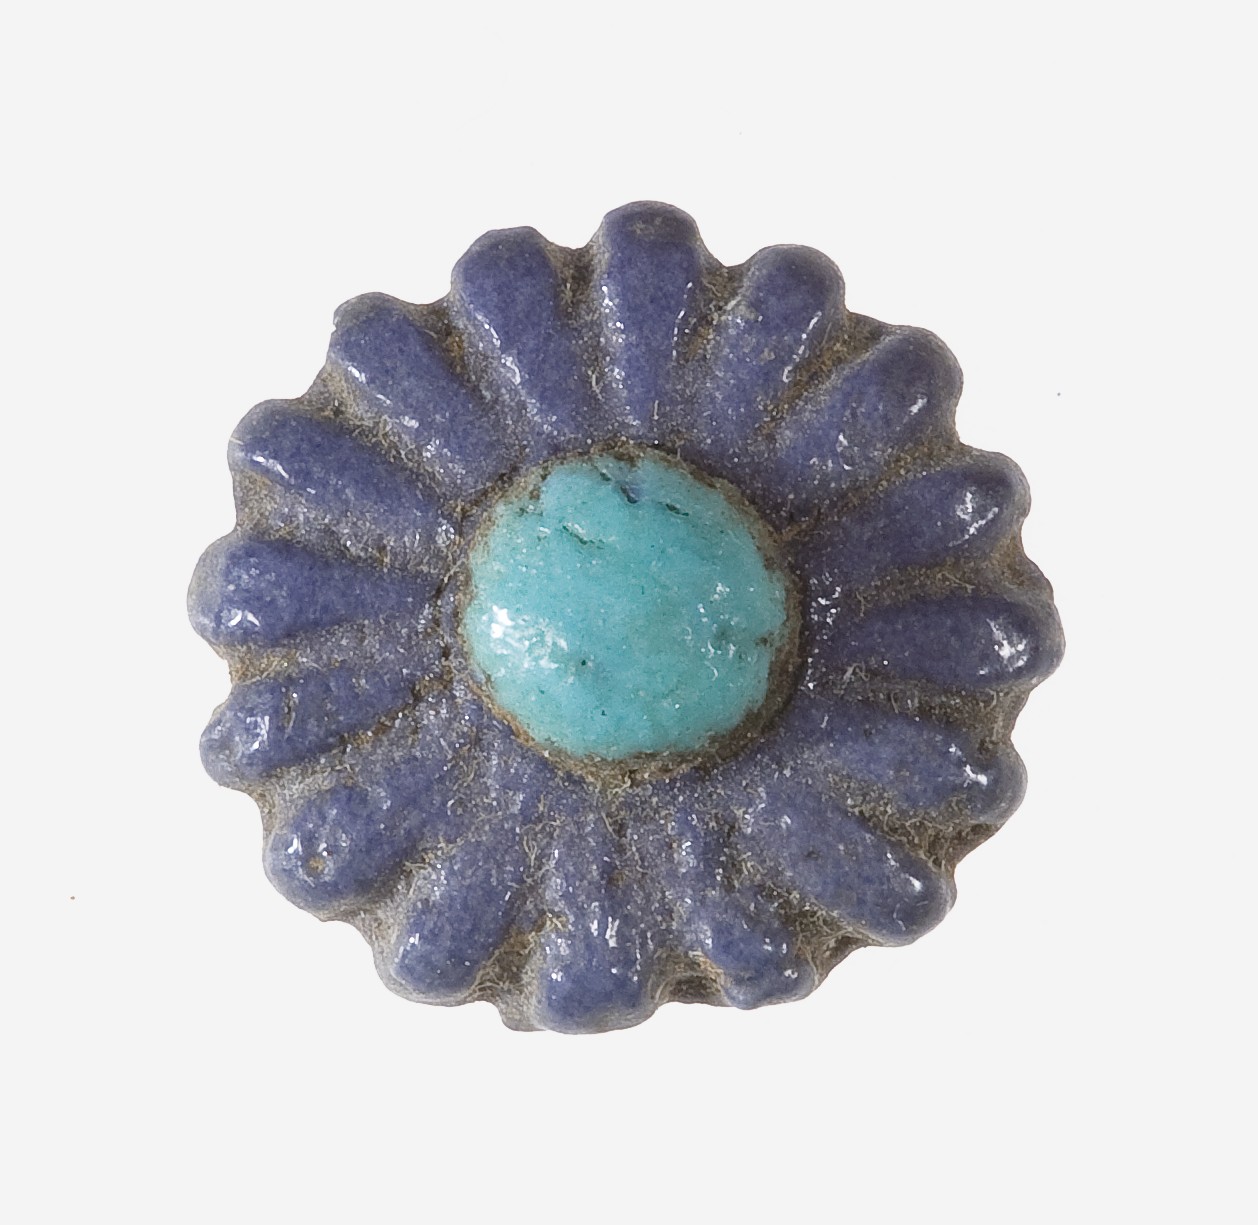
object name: pendant, daisy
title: Daisy Pendant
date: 1390-1352 BCE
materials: faience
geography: egypt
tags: daisies